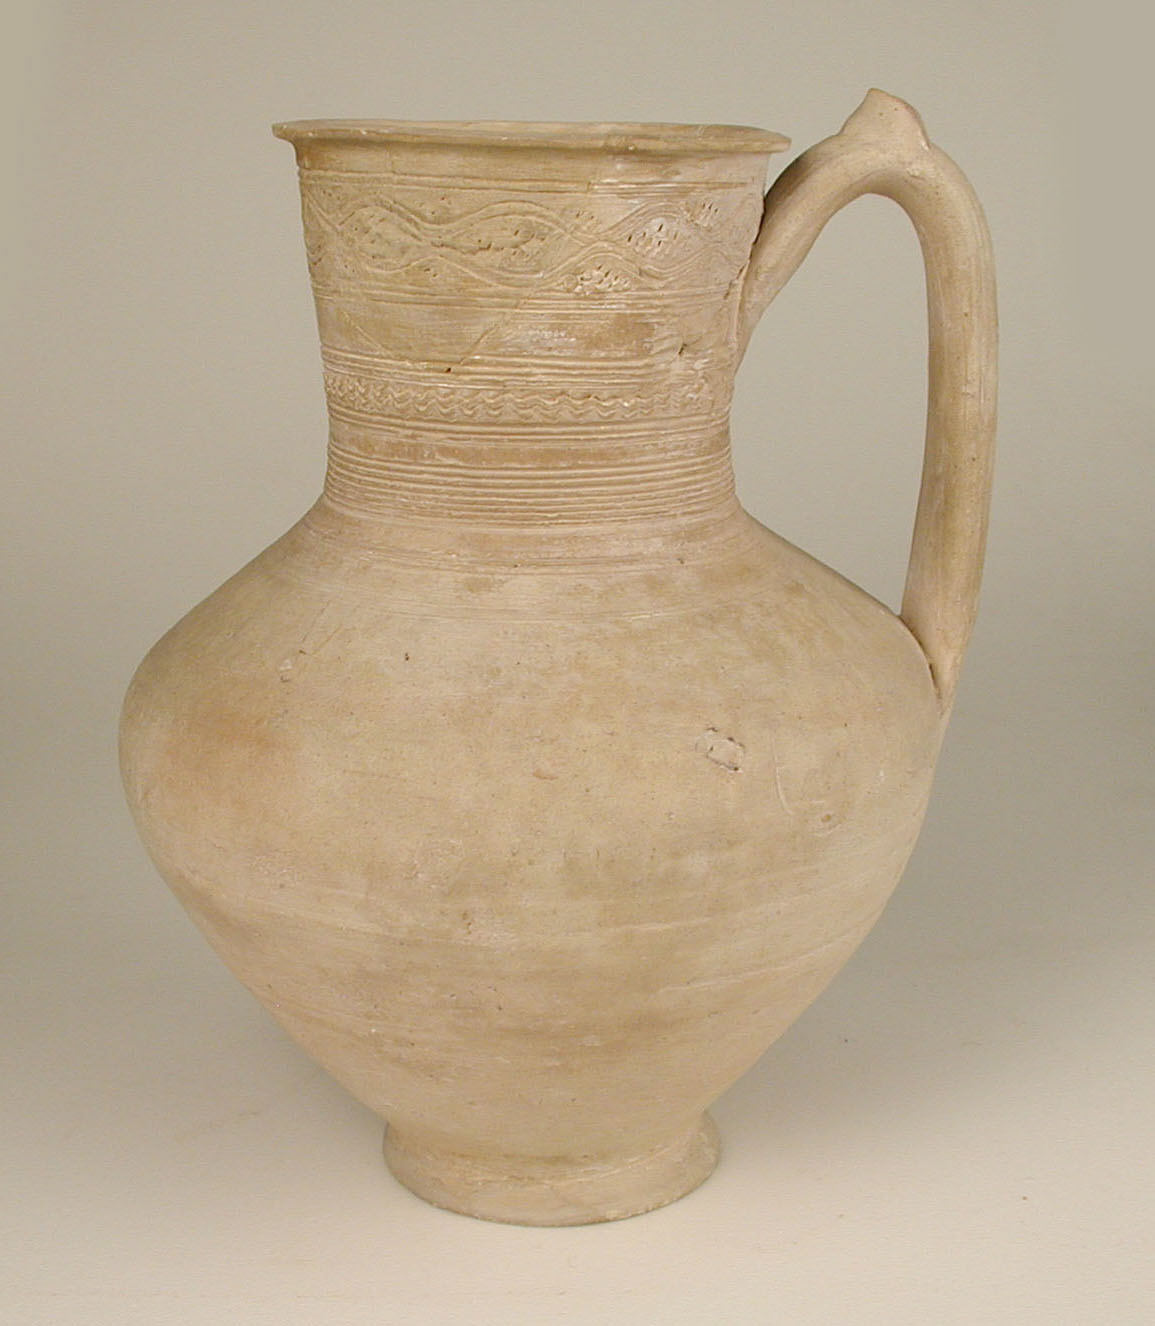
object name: ewer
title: Unglazed Ewer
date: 801-1000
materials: earthenware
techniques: incising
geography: iran